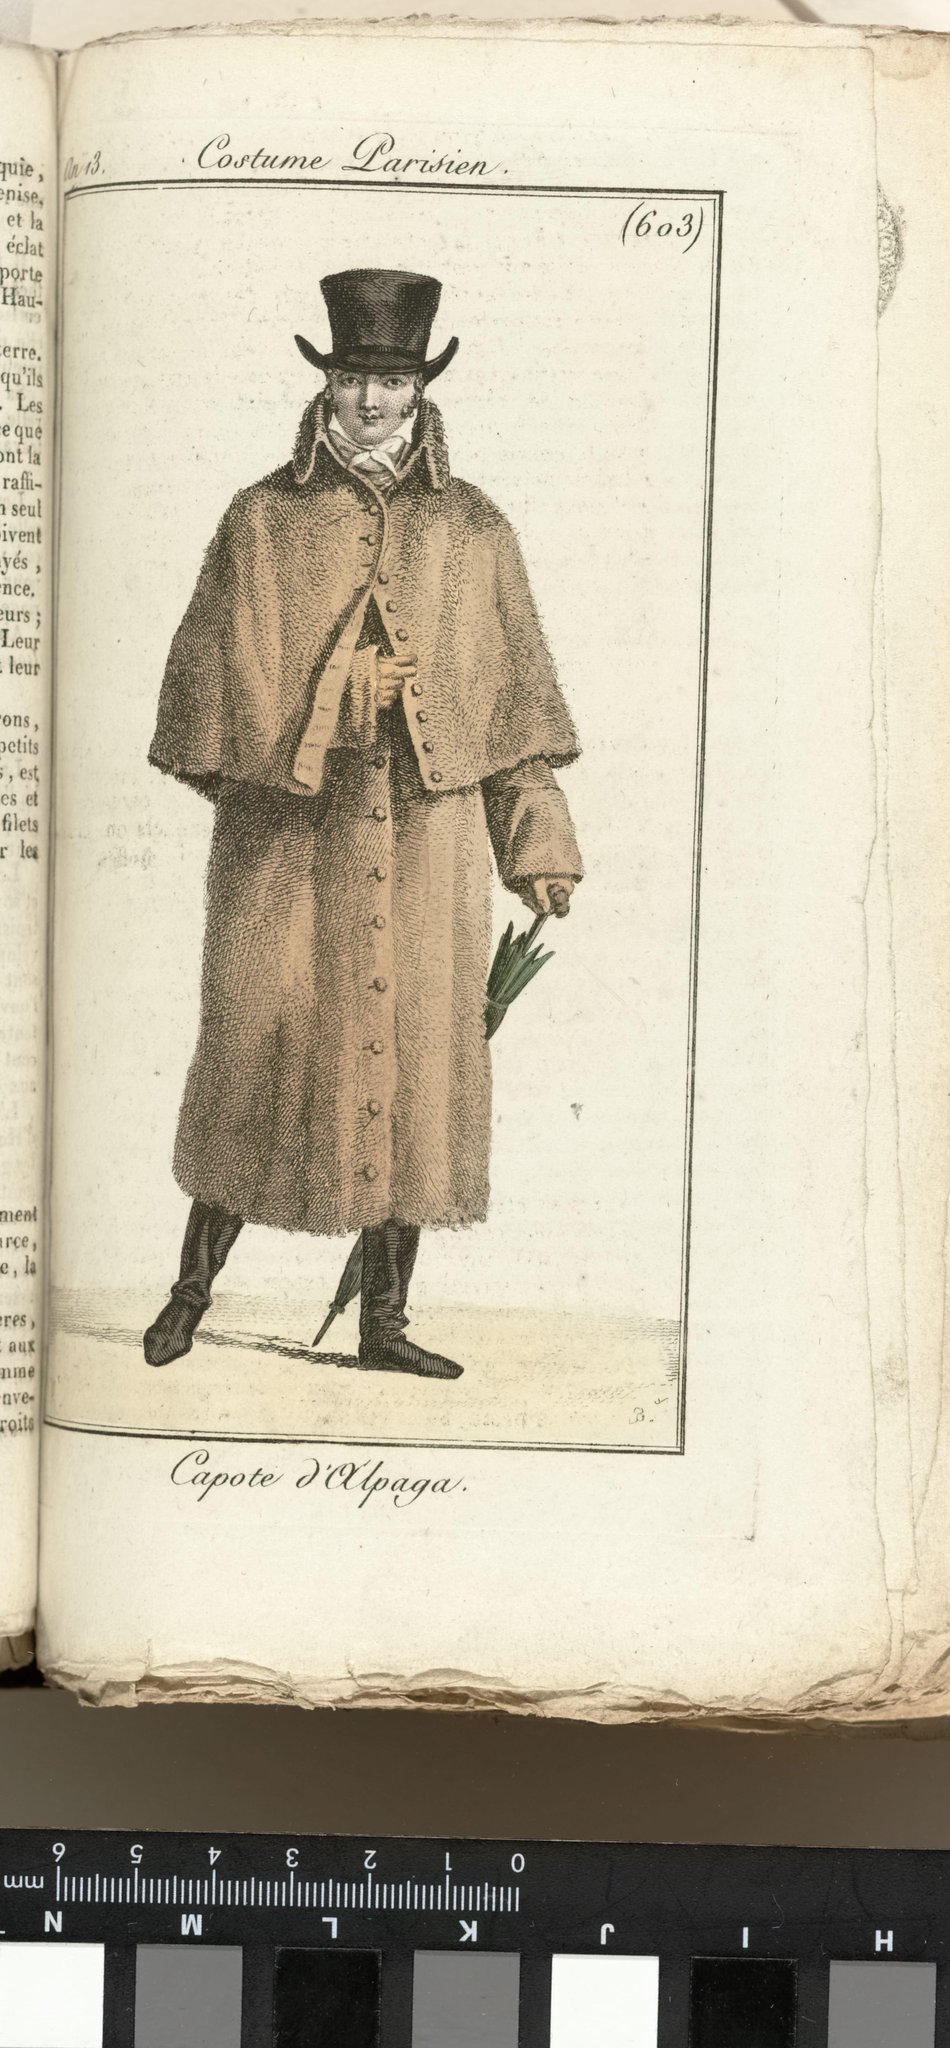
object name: fashion print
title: Journal des Dames et des Modes, Costume Parisien, 1805, An 13 (603) Capote d'Alpaga.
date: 1805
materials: paper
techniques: engraving, hand coloring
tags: coat (carrick) (+ men's clothes), umbrella (+ men's clothes), fashion plates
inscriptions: title: ‘Capote d'Alpaga.’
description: Man van voren gezien, gekleed in een lichtbruine bontmantel met pelerine (Carrick). Hoog gestrikte cravat. Op het hoofd een hoge hoed van alpaca met opstaande rand. Paraplu als wandelstok in de linkerhand. Platte schoenen. De prent maakt deel uit van het modetijdschrift Journal des Dames et des Modes, uitgegeven door Pierre de la Mésangère, Parijs, 1797-1839.